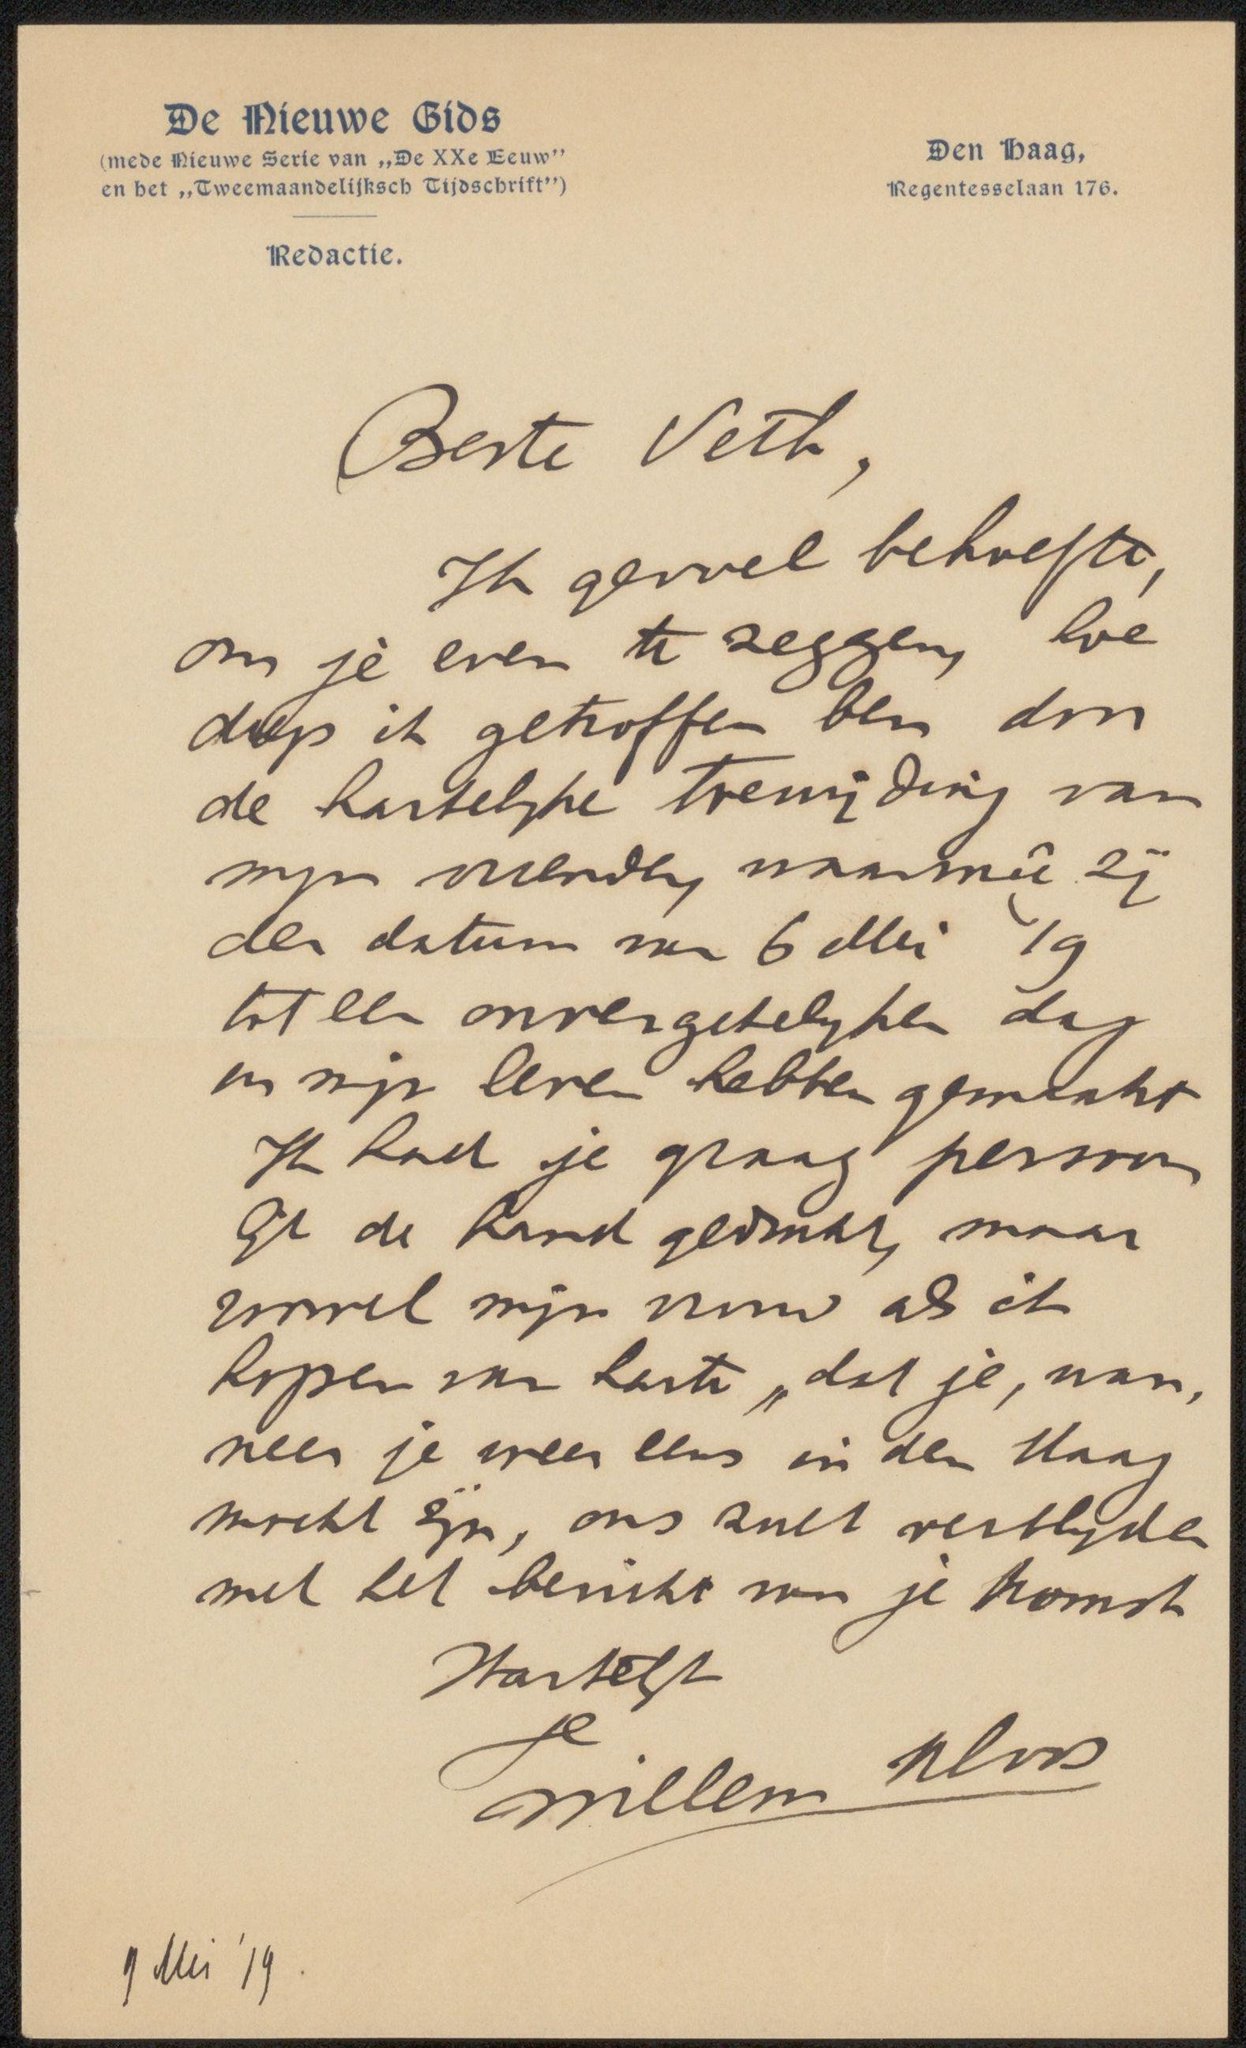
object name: letter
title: Brief aan Jan Veth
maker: willem kloos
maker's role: dichter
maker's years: 1859-1938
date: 1919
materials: ink, paper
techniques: pen, printing, writing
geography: the hague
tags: dordrecht, amsterdam, painter, draughtsman, designer, jan veth, passions, emotions, affections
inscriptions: collector's mark: ‘RPK’